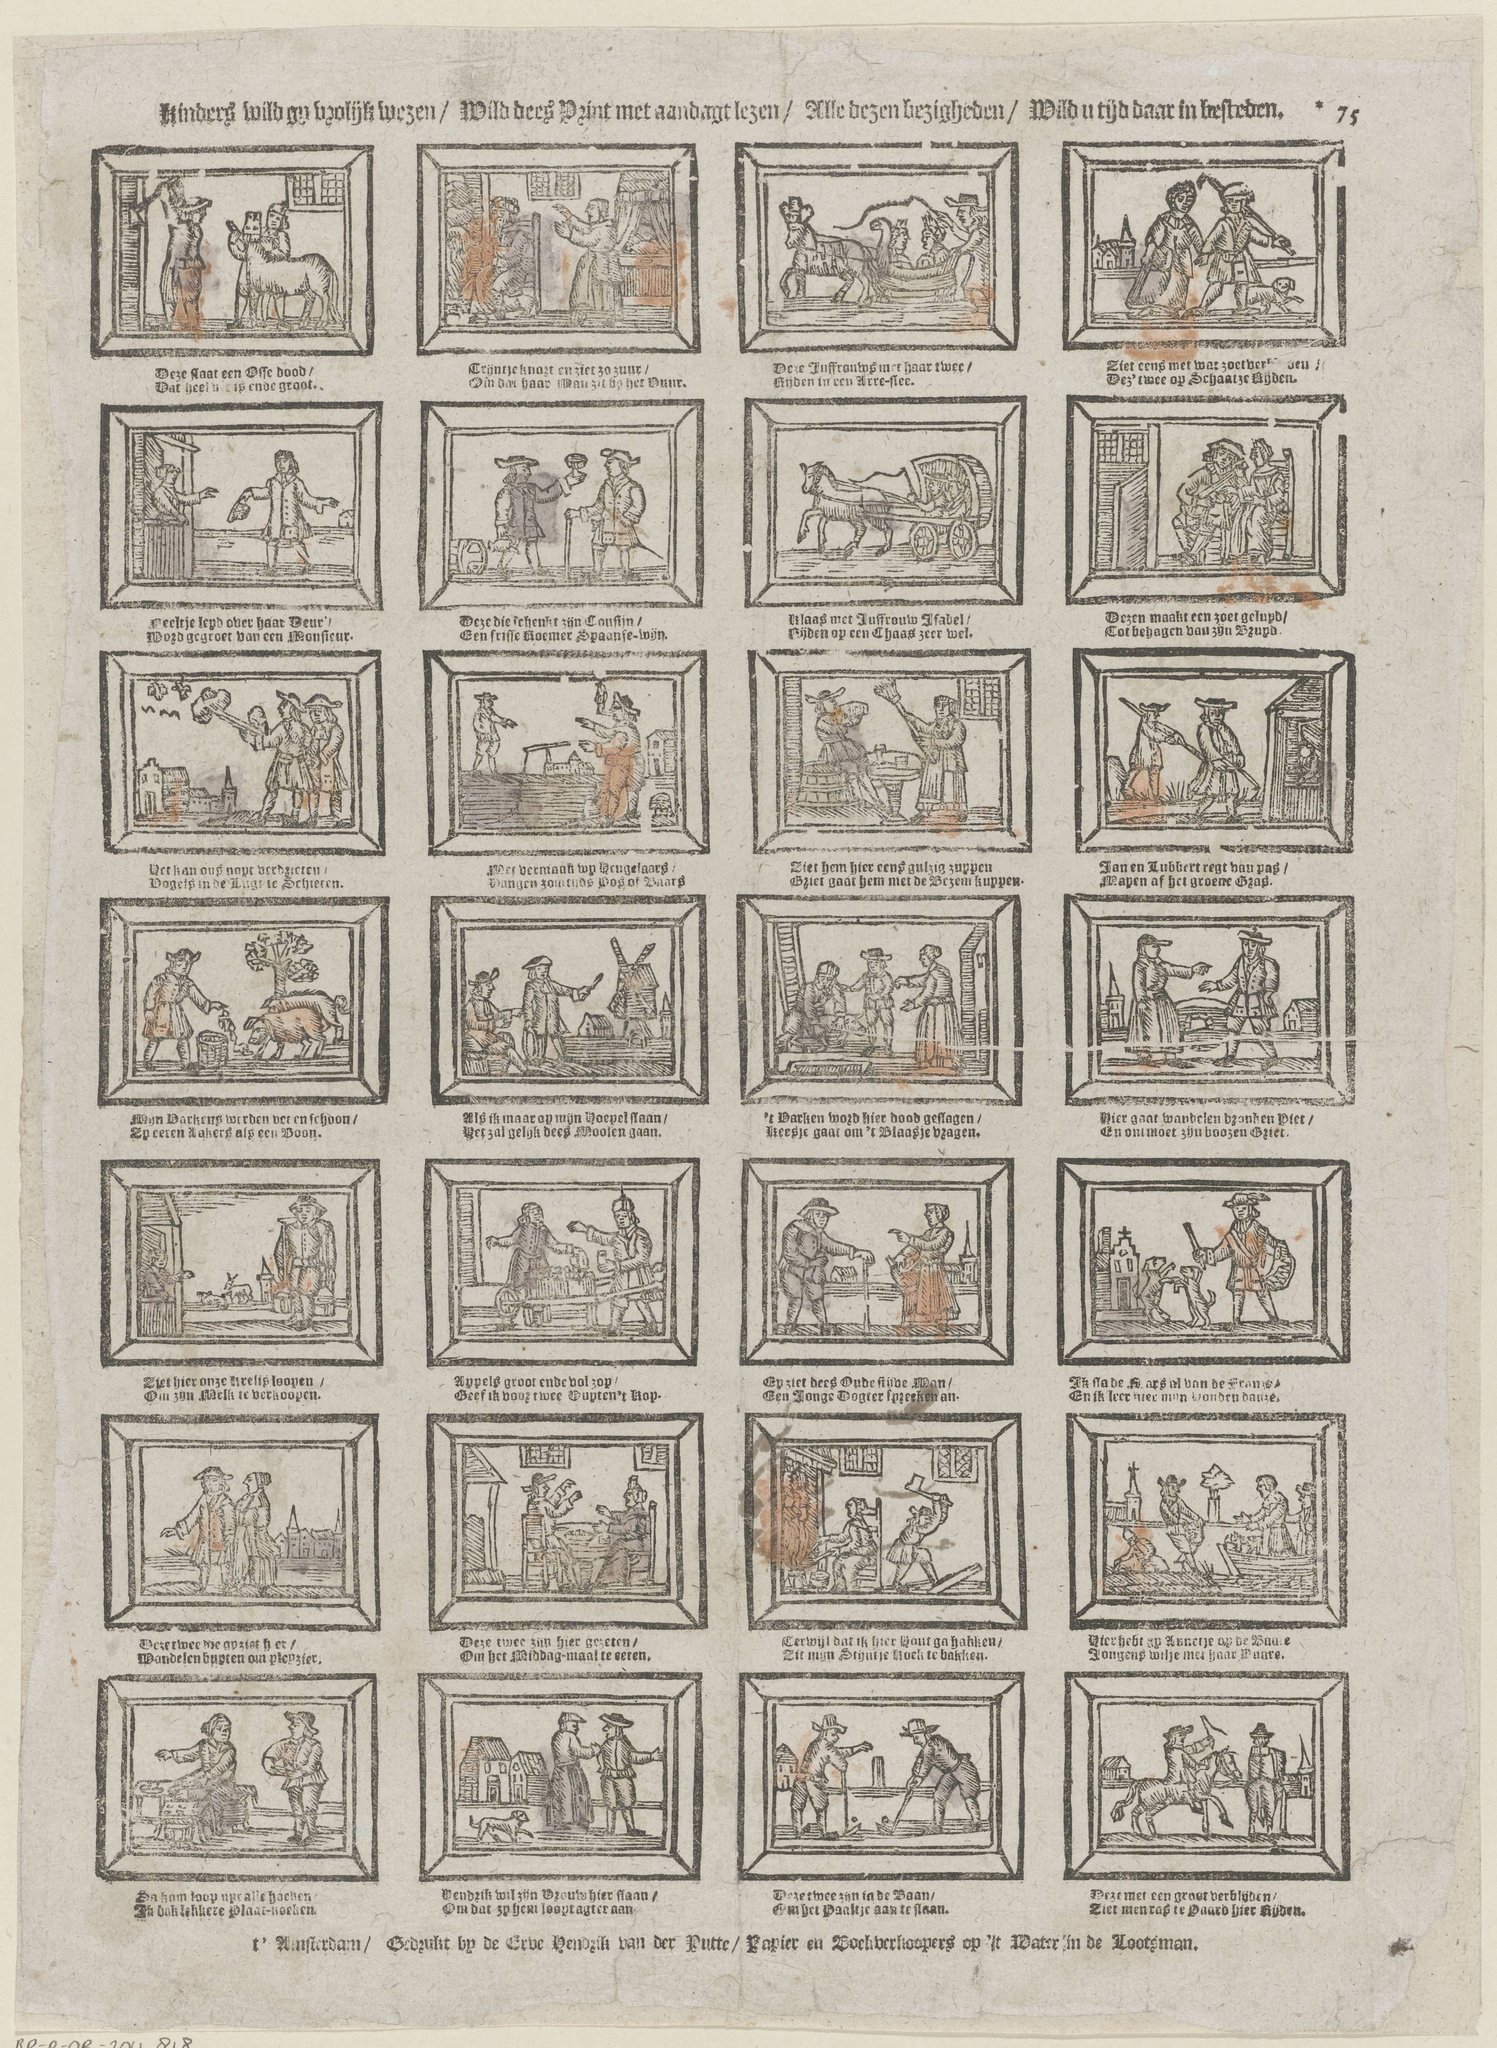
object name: print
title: Kinders wild gy vrolijk wezen / Wild dees print met aandagt lezen / Alle dezen bezigheden / Wild u tijd daar in besteden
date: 1767-1793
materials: paper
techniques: colour, letterpress printing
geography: amsterdam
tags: human types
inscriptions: collector's mark: Lugt 2760, inscription: ‘JCP / no / 1925’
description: Blad met 28 voorstellingen van verschillende bezigheden. Onder elke afbeelding een tweeregelig vers. Genummerd rechtsboven: *75.